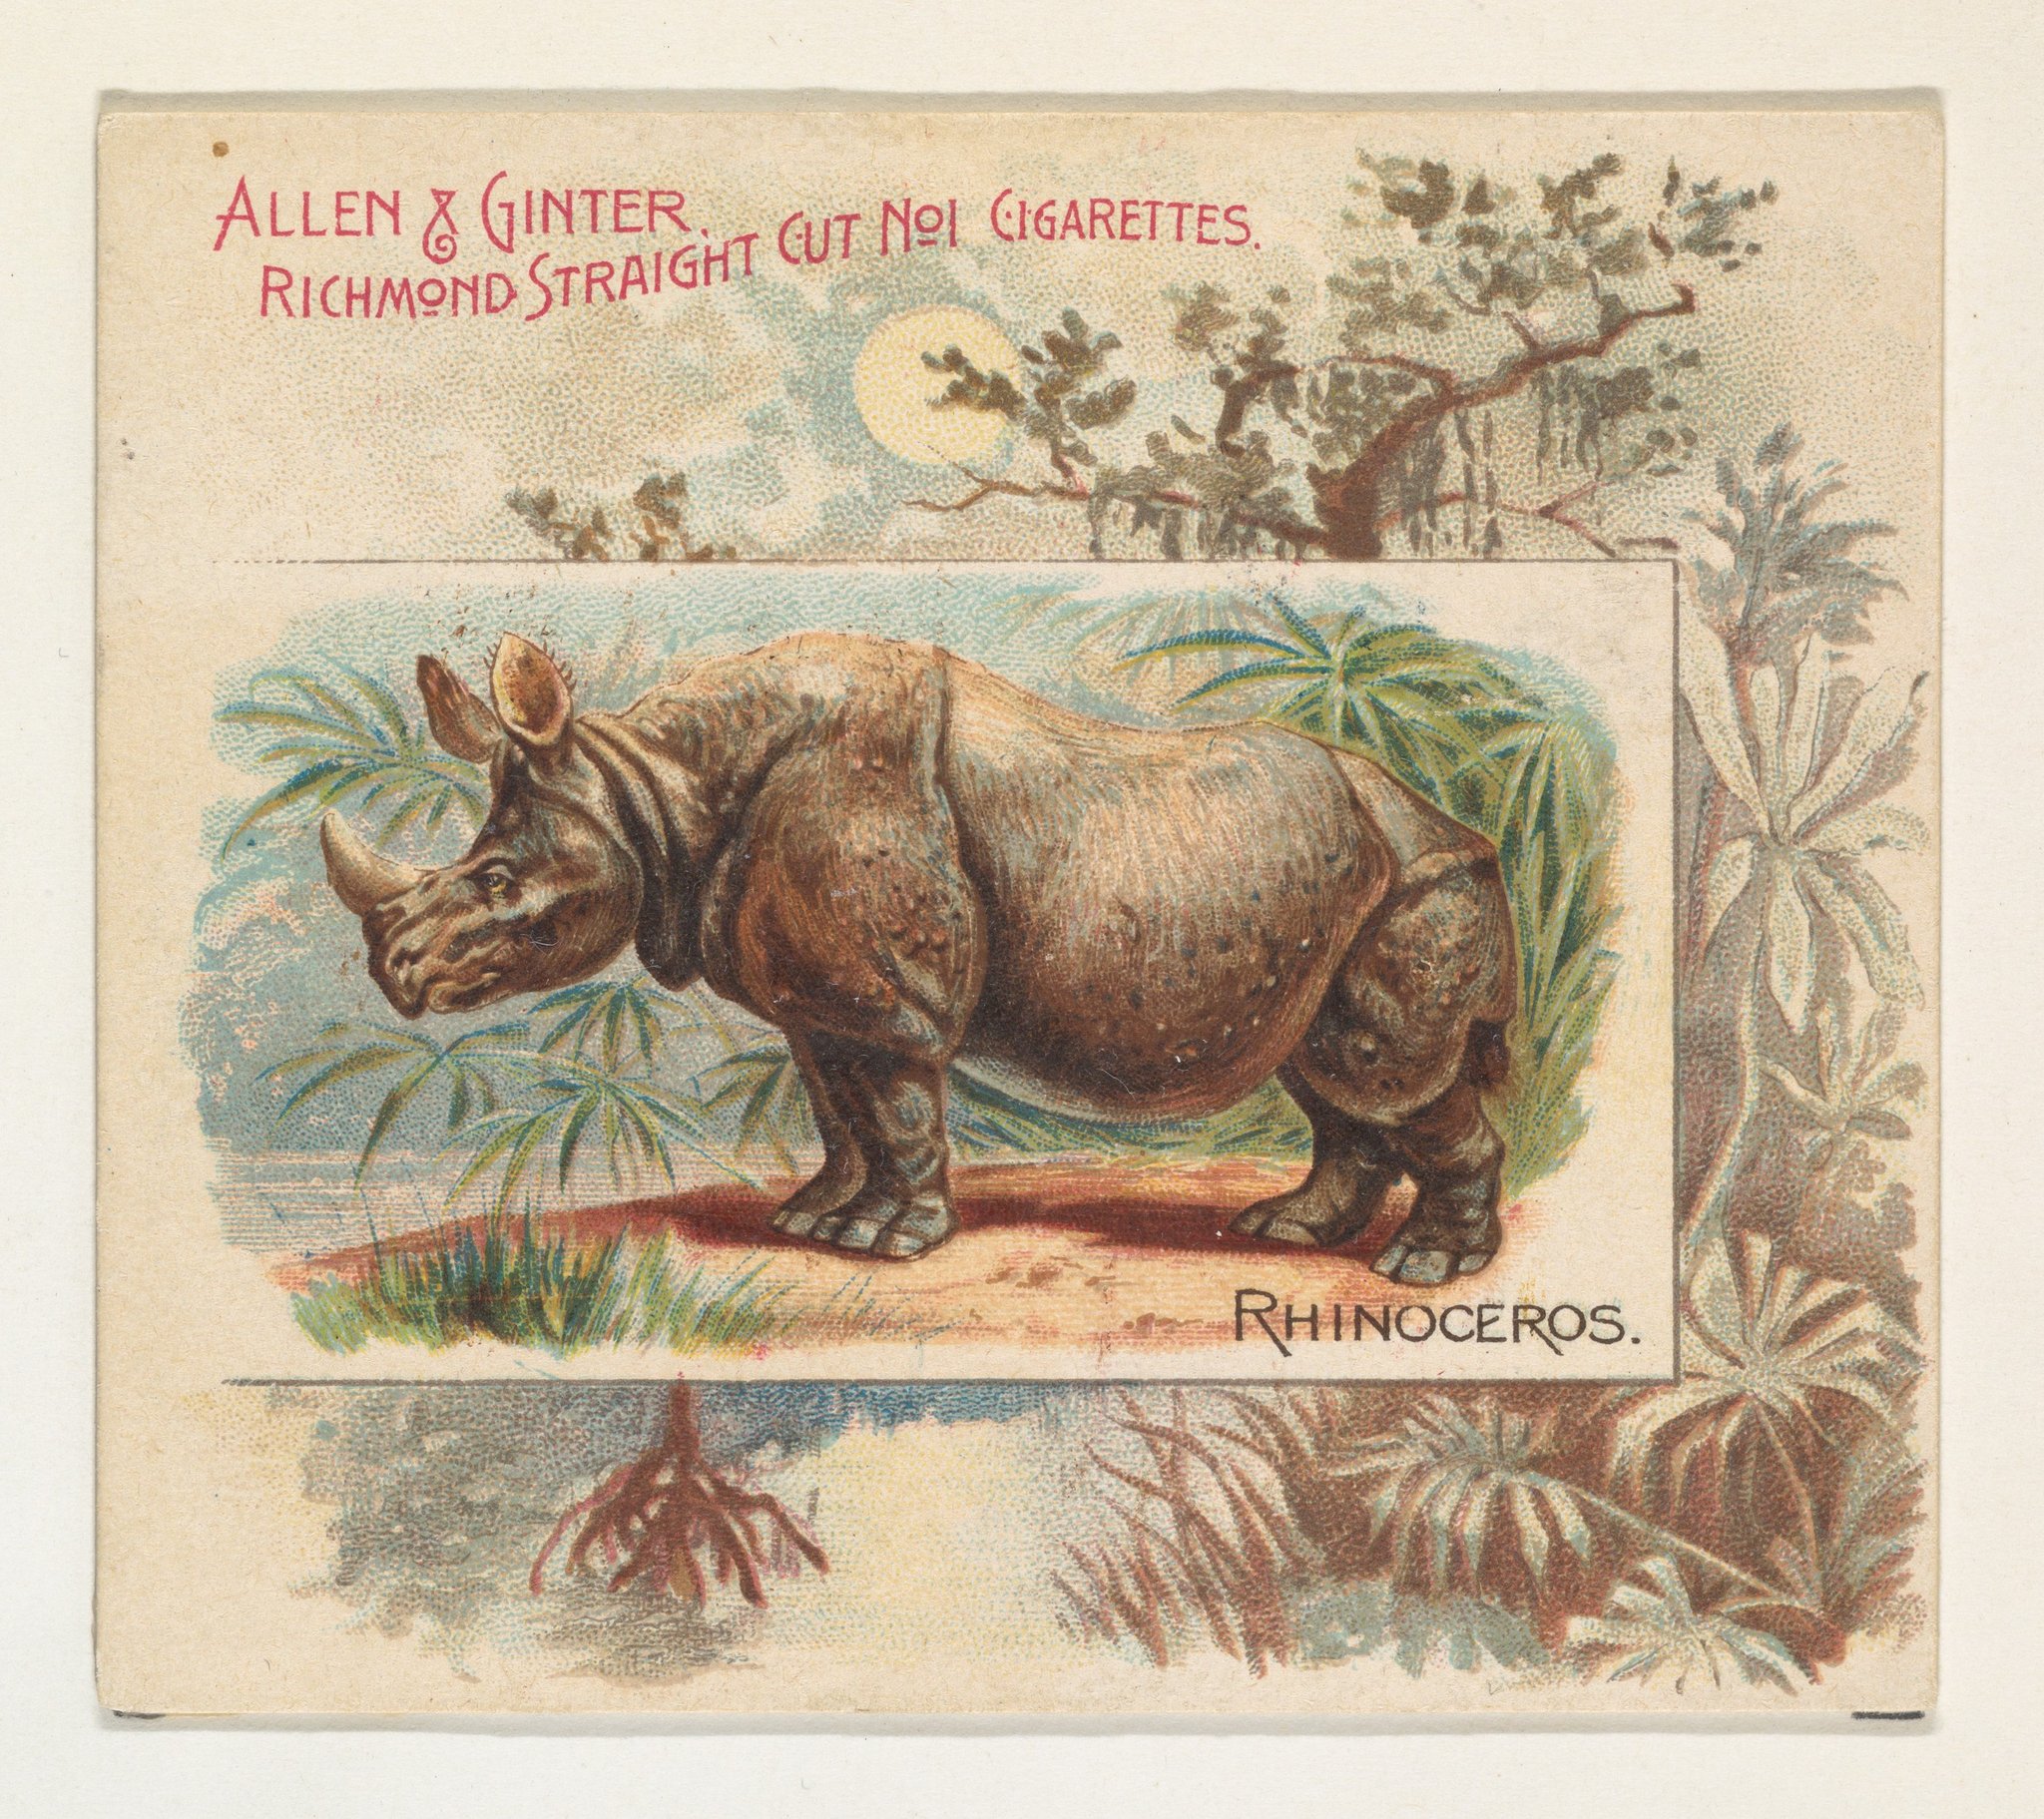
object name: print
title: Rhinoceros, from Quadrupeds series (N41) for Allen & Ginter Cigarettes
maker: allen & ginter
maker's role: publisher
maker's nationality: american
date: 1890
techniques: color lithograph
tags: animals